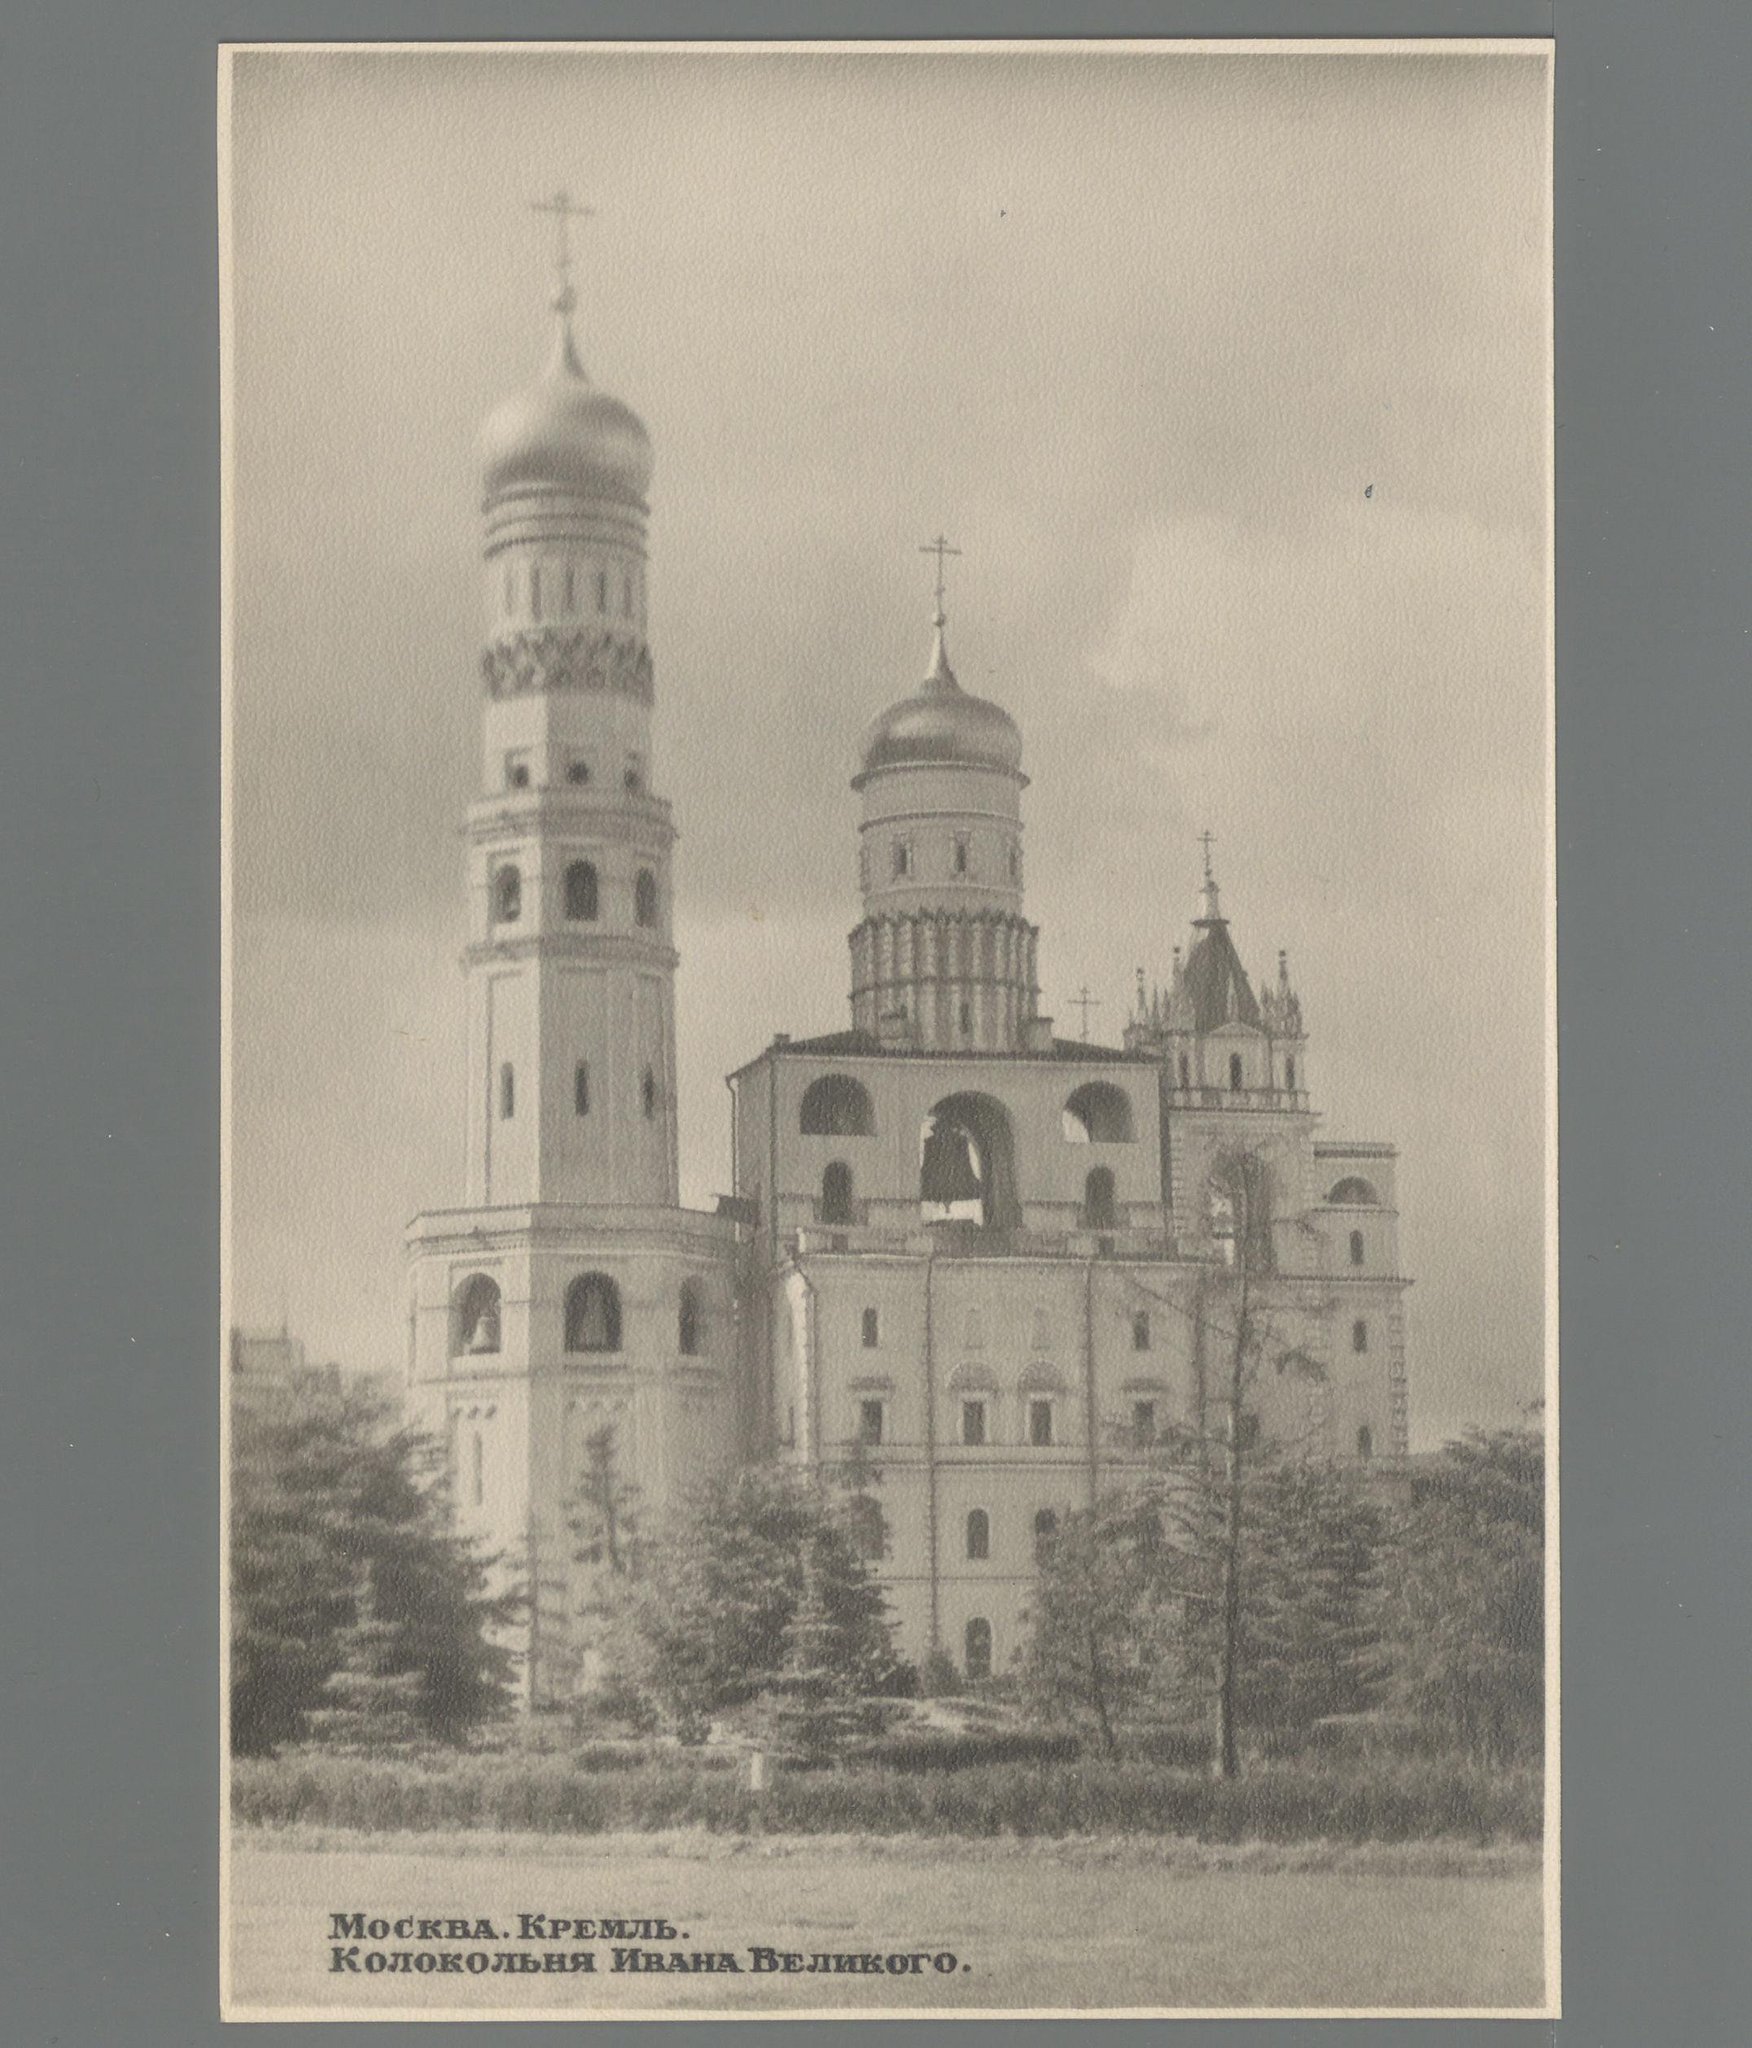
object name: photograph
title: Gezicht op de klokkentoren van Ivan de Grote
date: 1954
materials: paper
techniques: gelatin silver print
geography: moscow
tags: parts of church exterior and annexes: campanile, church (exterior)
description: De titel op object staat in het Russisch.